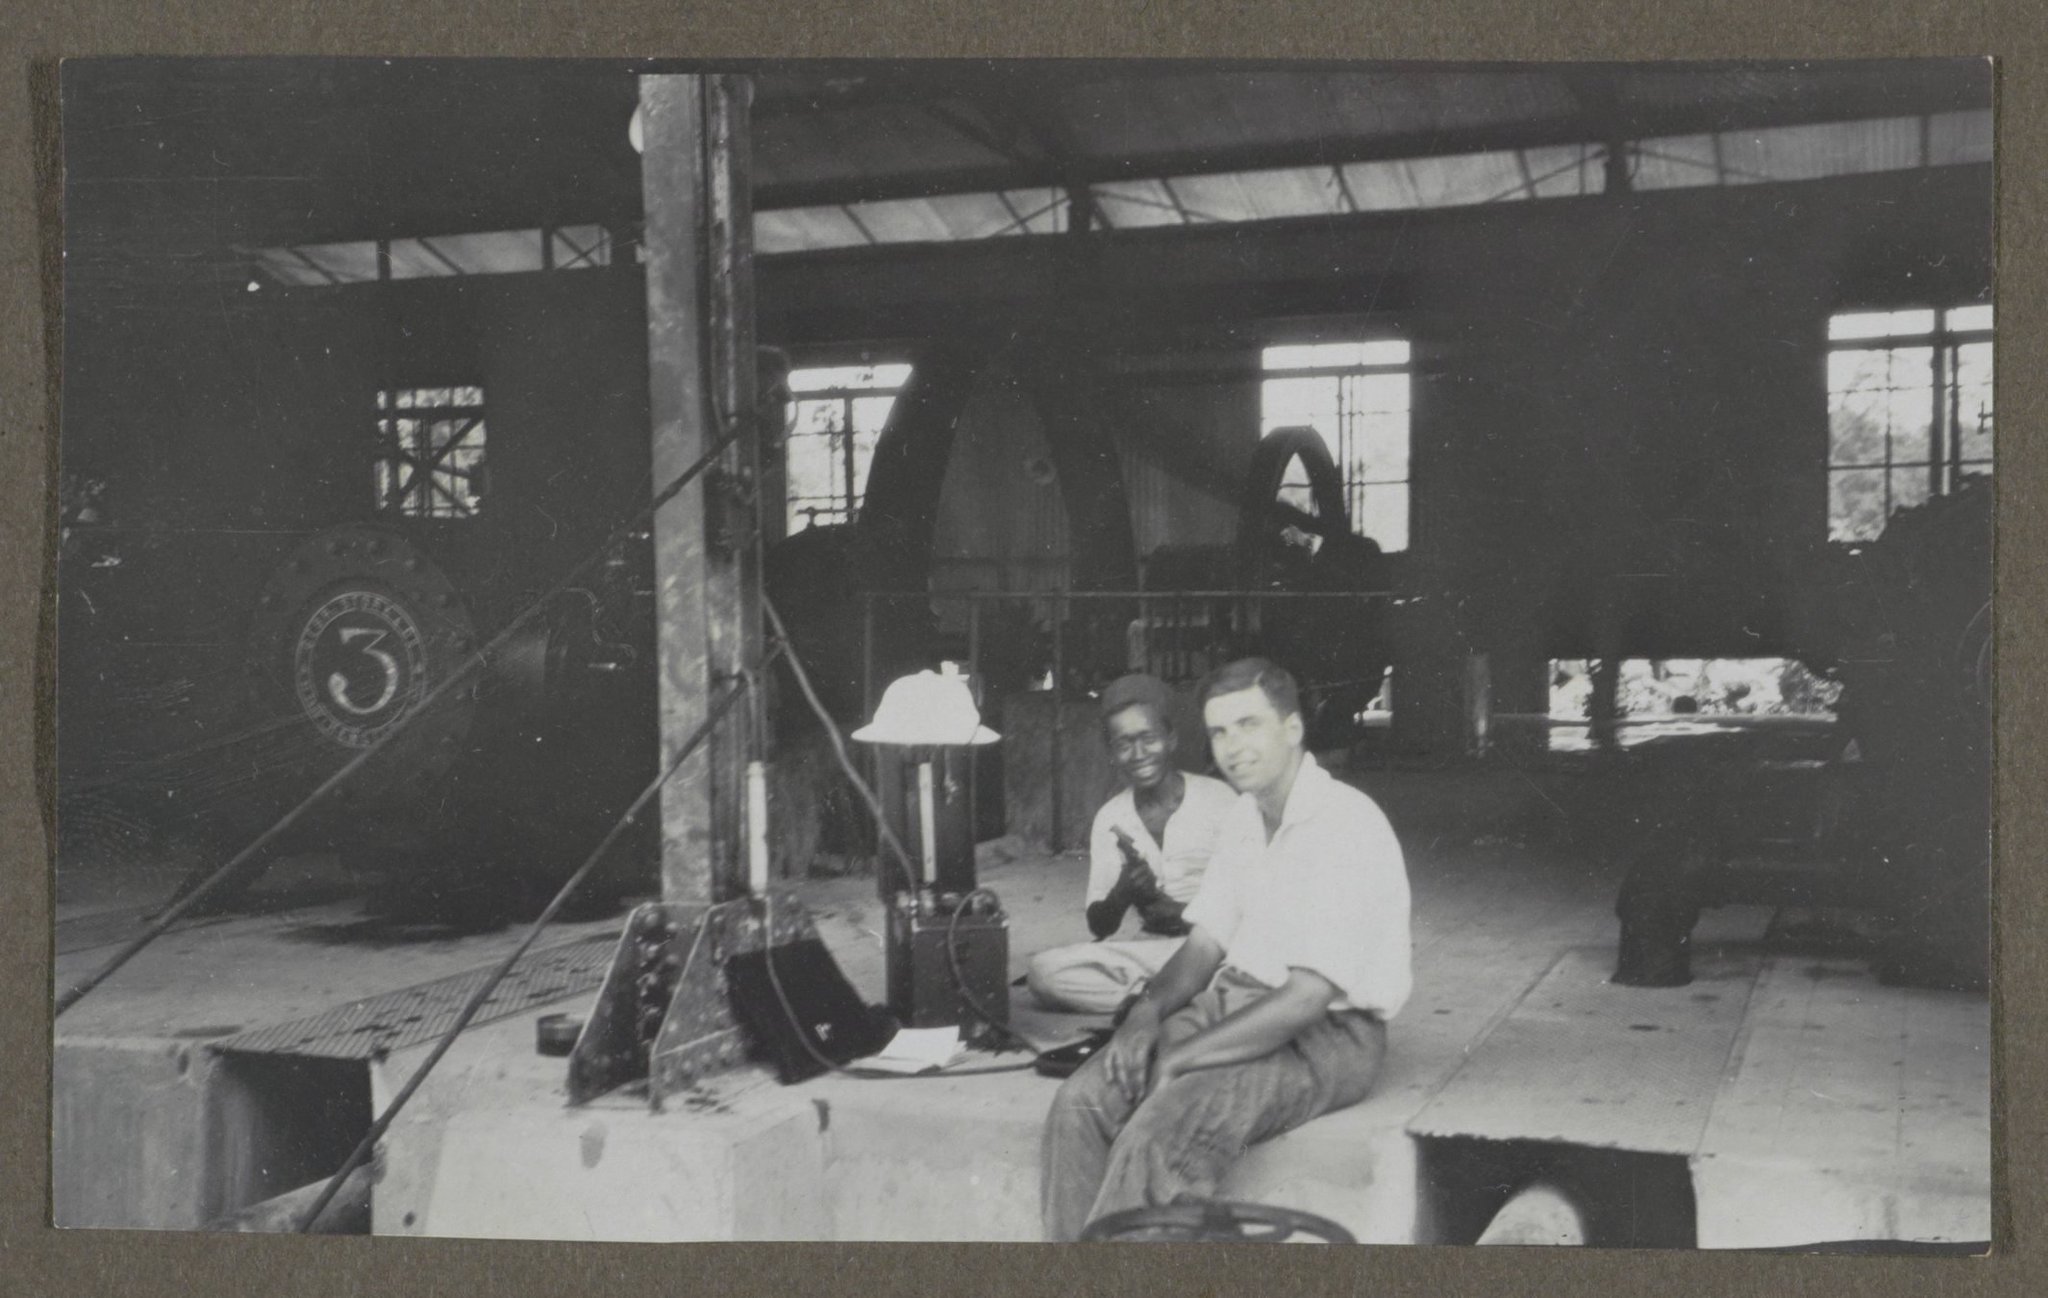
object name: photograph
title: Twee mannen zittend op de vloer van een machinekamer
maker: Anonymous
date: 1920-1930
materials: photographic support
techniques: gelatin silver print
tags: machines, engines ~ crafts and industries, dutch east indies, the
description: Twee mannen, waarvan één Indisch, zitten voor een machine met een drijfriem. Eén van de machines heeft het cijfer 3 als opschrift. Naast hen staat apparatuur met snoeren. Een tropenhelm is op een apparaat gelegd. Onderdeel van familiealbum Nederlands-Indië.